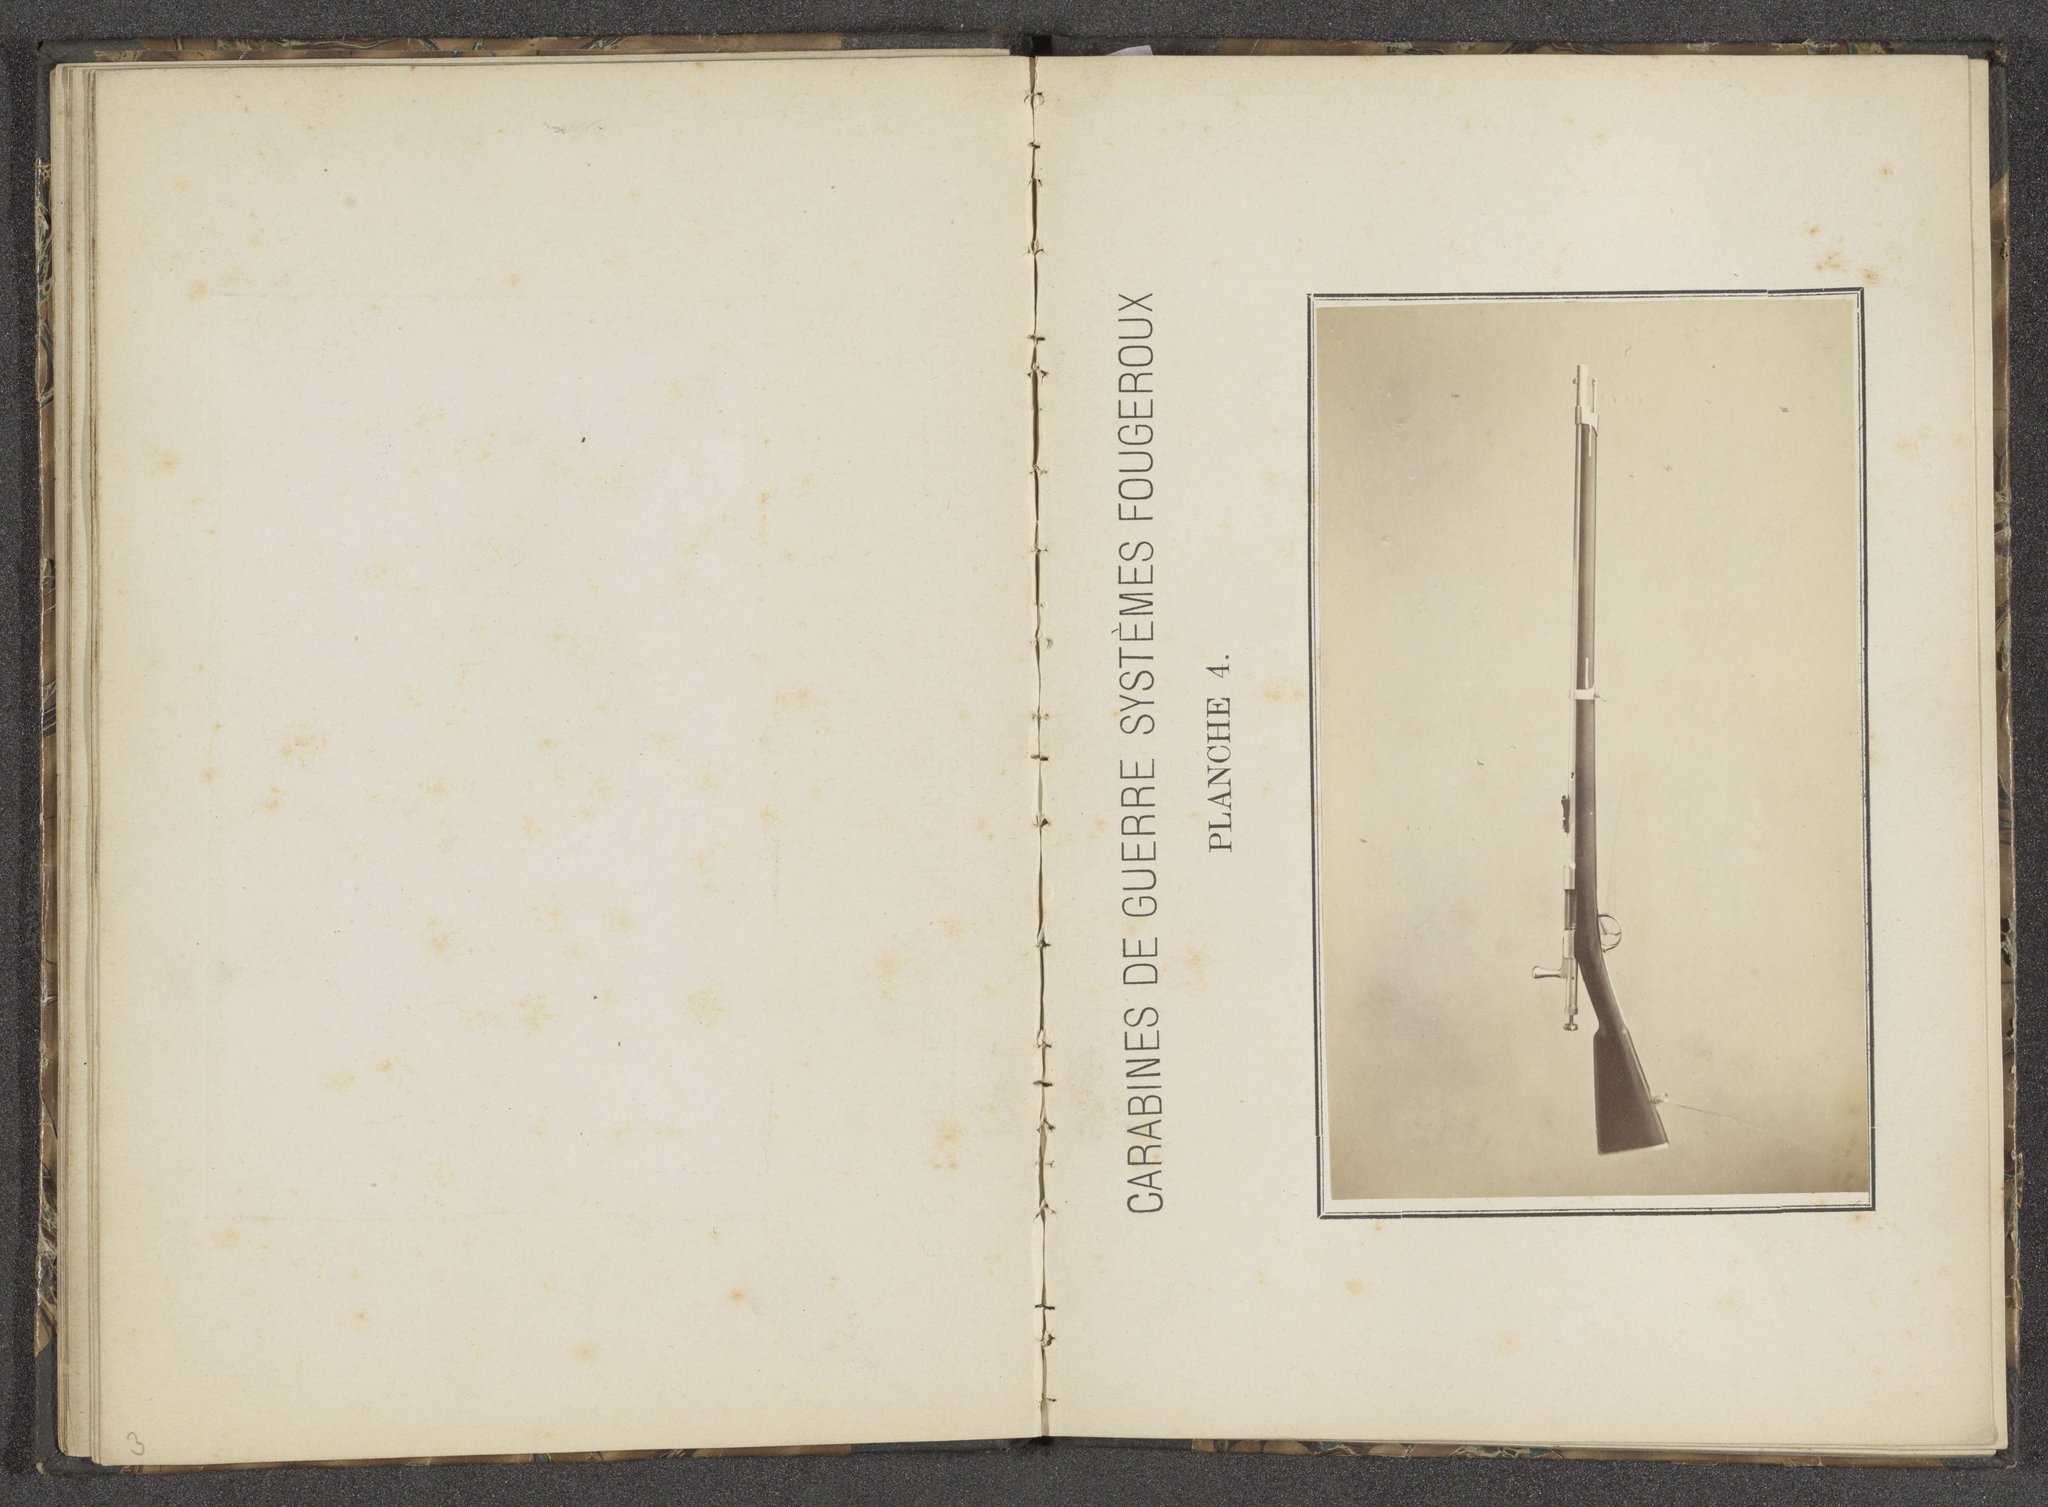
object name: page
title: Geweer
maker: edouard magis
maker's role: fotograaf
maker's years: 1828-1906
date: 1857-1867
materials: photographic support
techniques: albumen print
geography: liège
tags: firearms: rifle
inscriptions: inscription: ‘Carabines de guerres systèmes Fougeroux’, number: ‘Planche 4.’